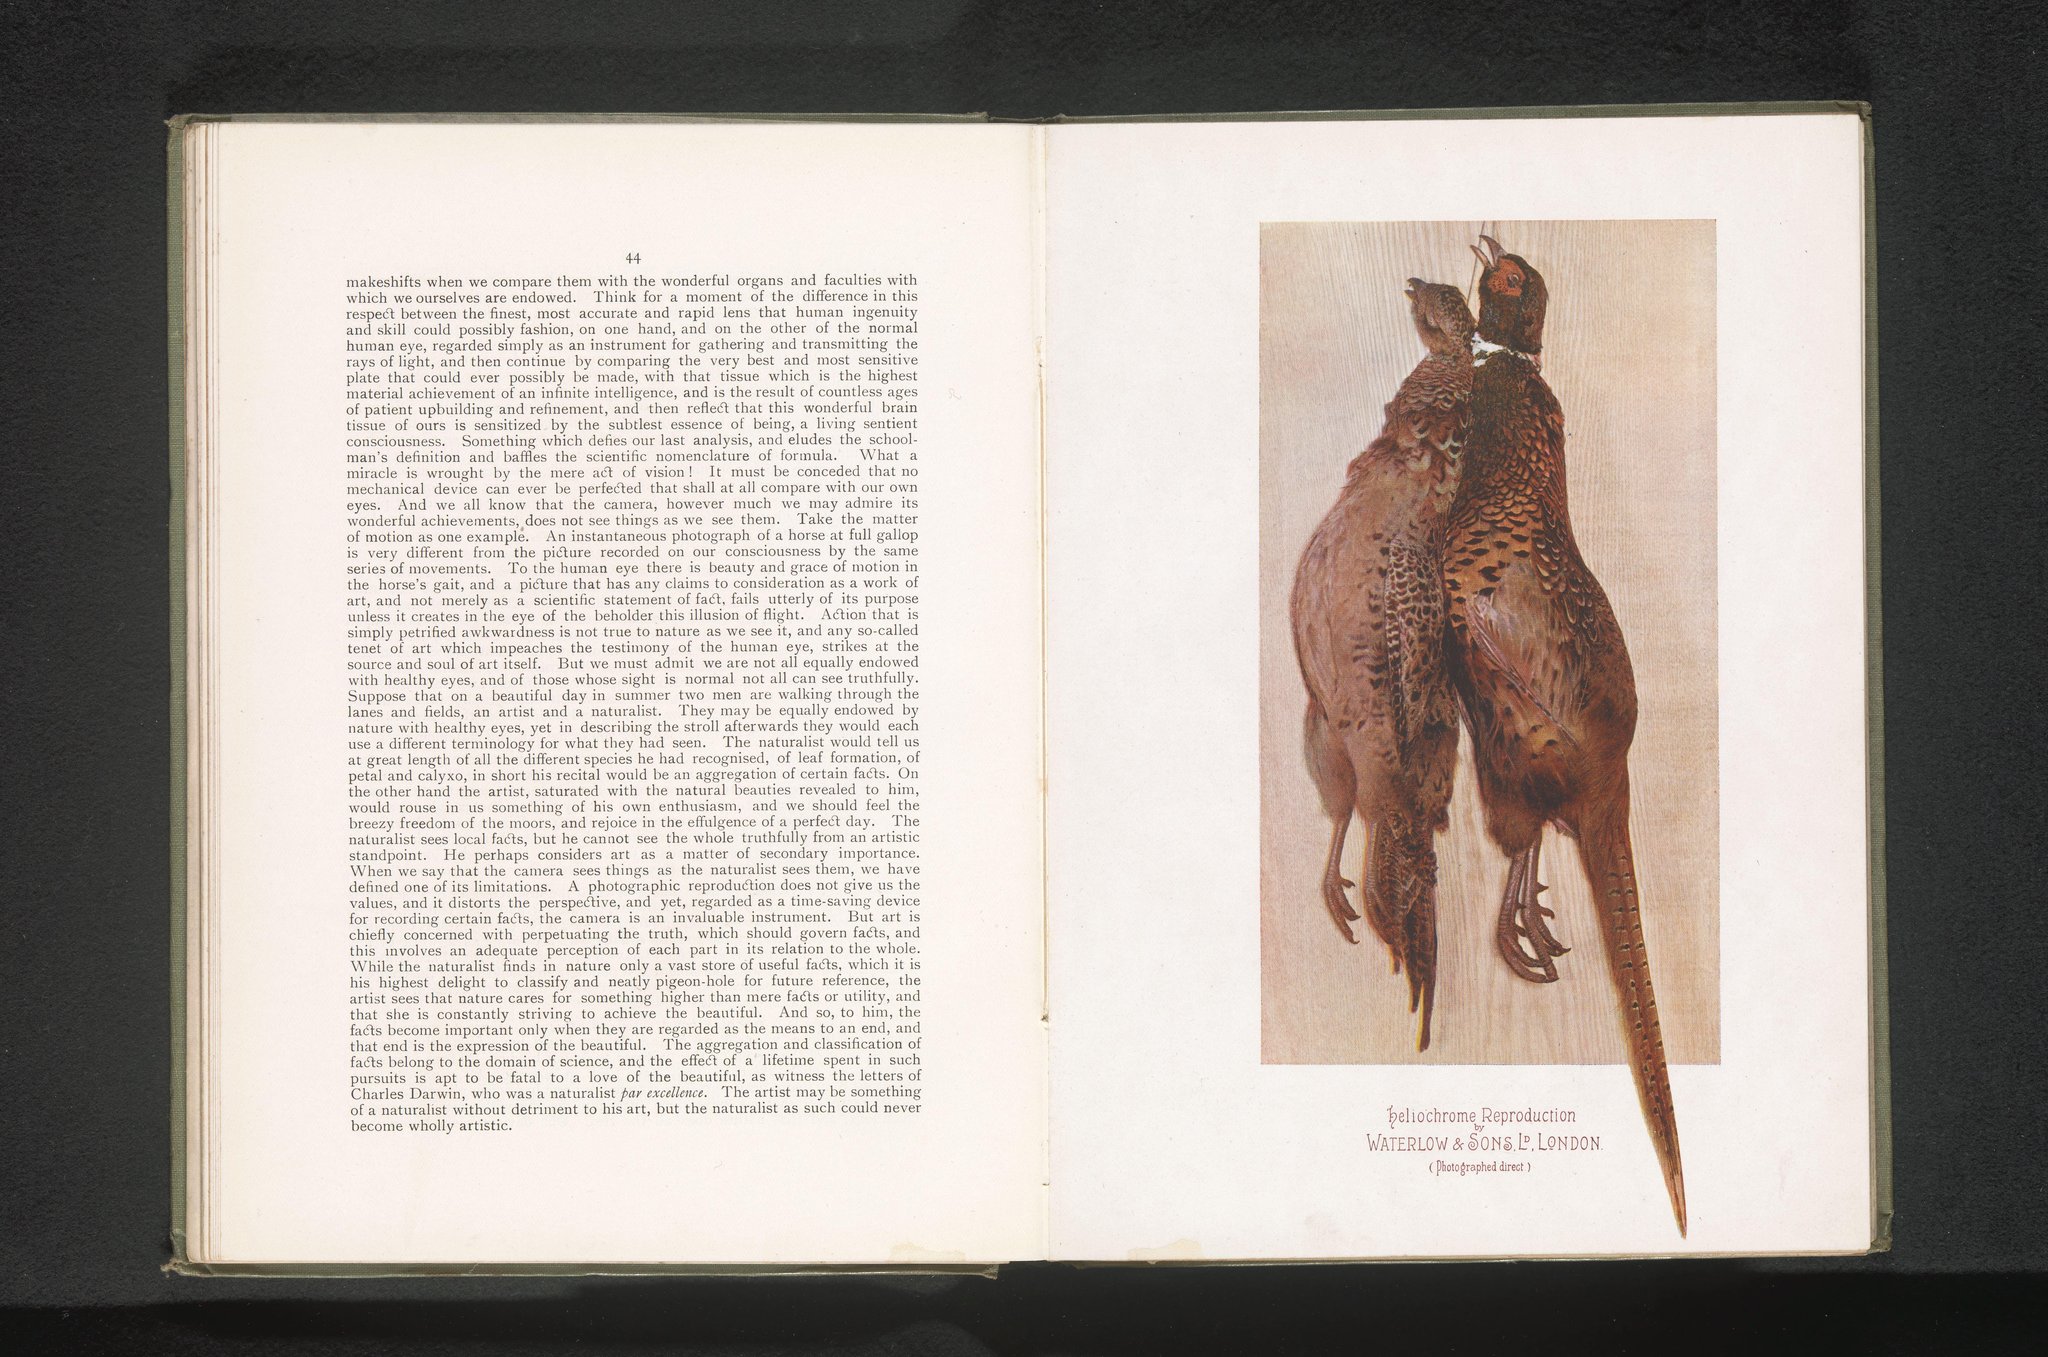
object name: reproduction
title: Reproductie van een ontwerp van twee geschoten fazanten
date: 1893-1898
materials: paper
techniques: three-color autotype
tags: walker and runner birds: pheasant